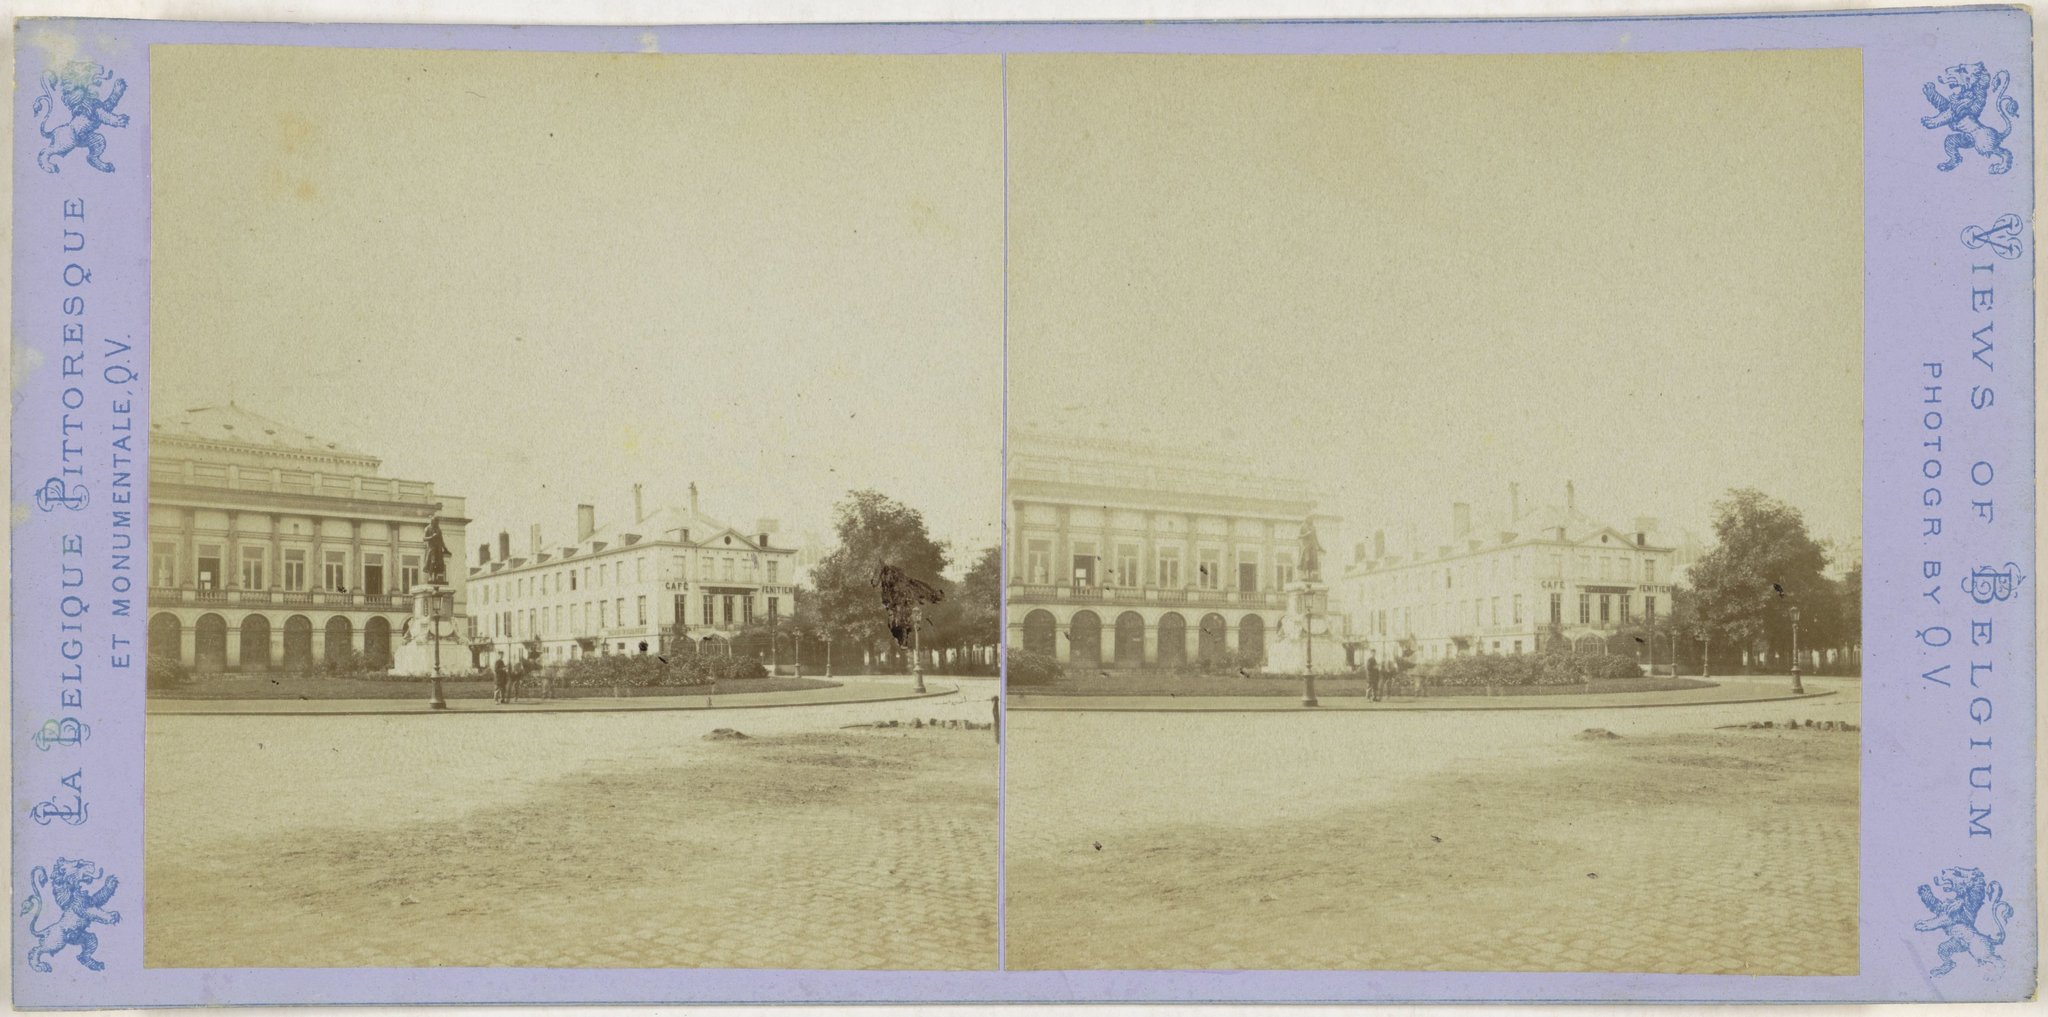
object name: stereograph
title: La Belgique pittoresque et monumentale / Views of Belgium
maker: jules hippolyte quéval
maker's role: publisher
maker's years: 1824-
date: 1866-1870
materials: cardboard, paper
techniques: albumen print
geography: liège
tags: square, place, circus, etc., monument, statue, opera house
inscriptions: number: ‘No 1772’